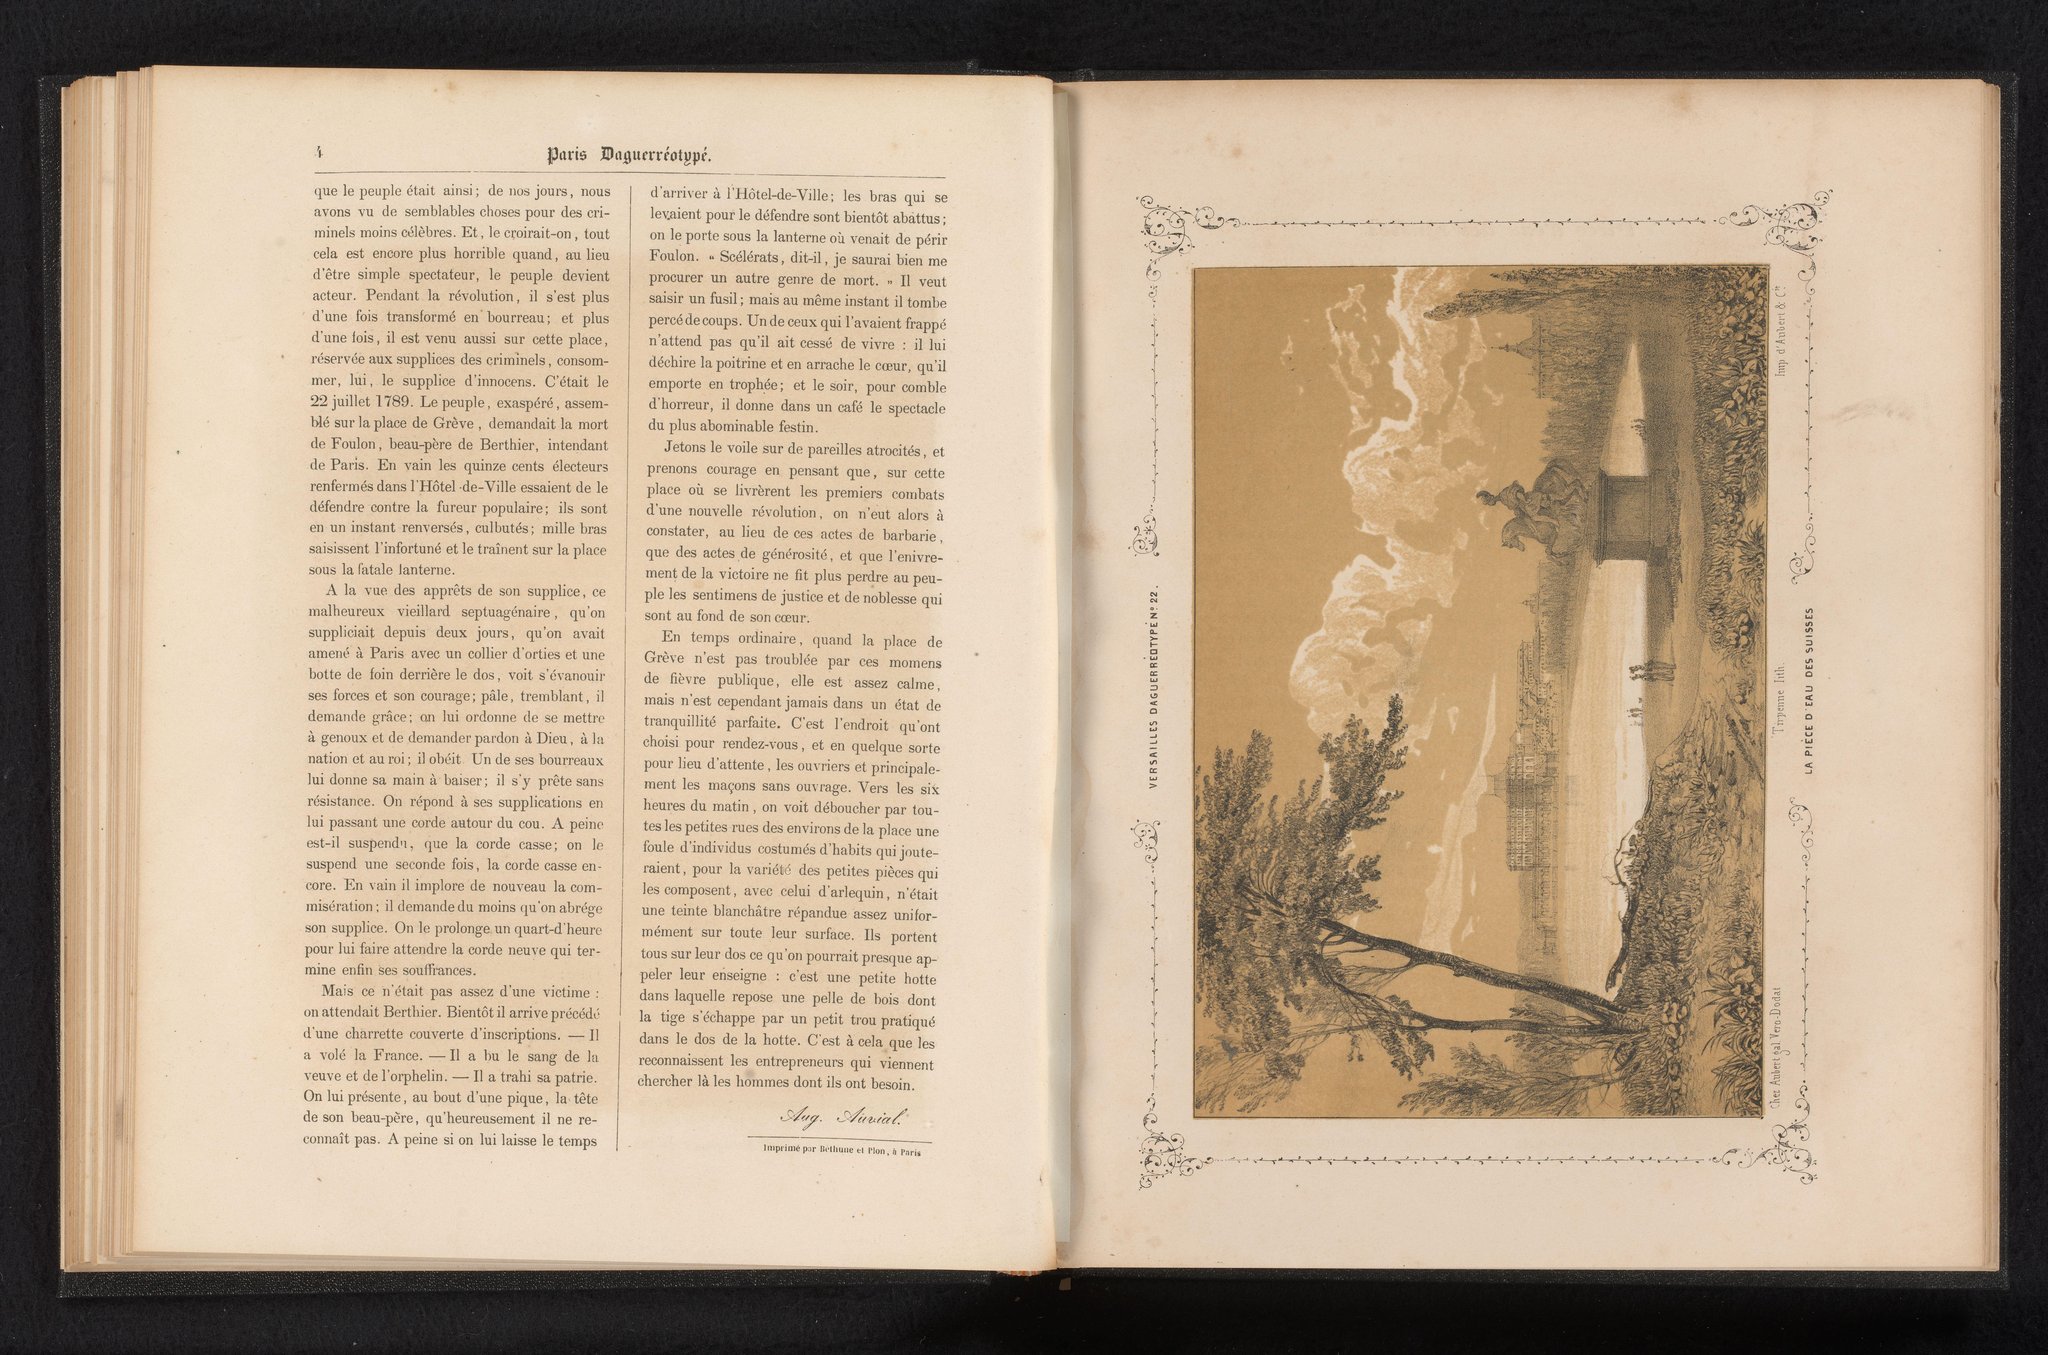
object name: print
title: Pièce d'eau des Suisses bij Versailles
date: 1839-1840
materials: paper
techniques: tone lithography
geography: paris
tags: pond, pool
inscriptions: inscription: ‘PARIS DAGUERRÉOTYPÉ No. 22.’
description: Prent op zevenentachtigste ongenummerde pagina.